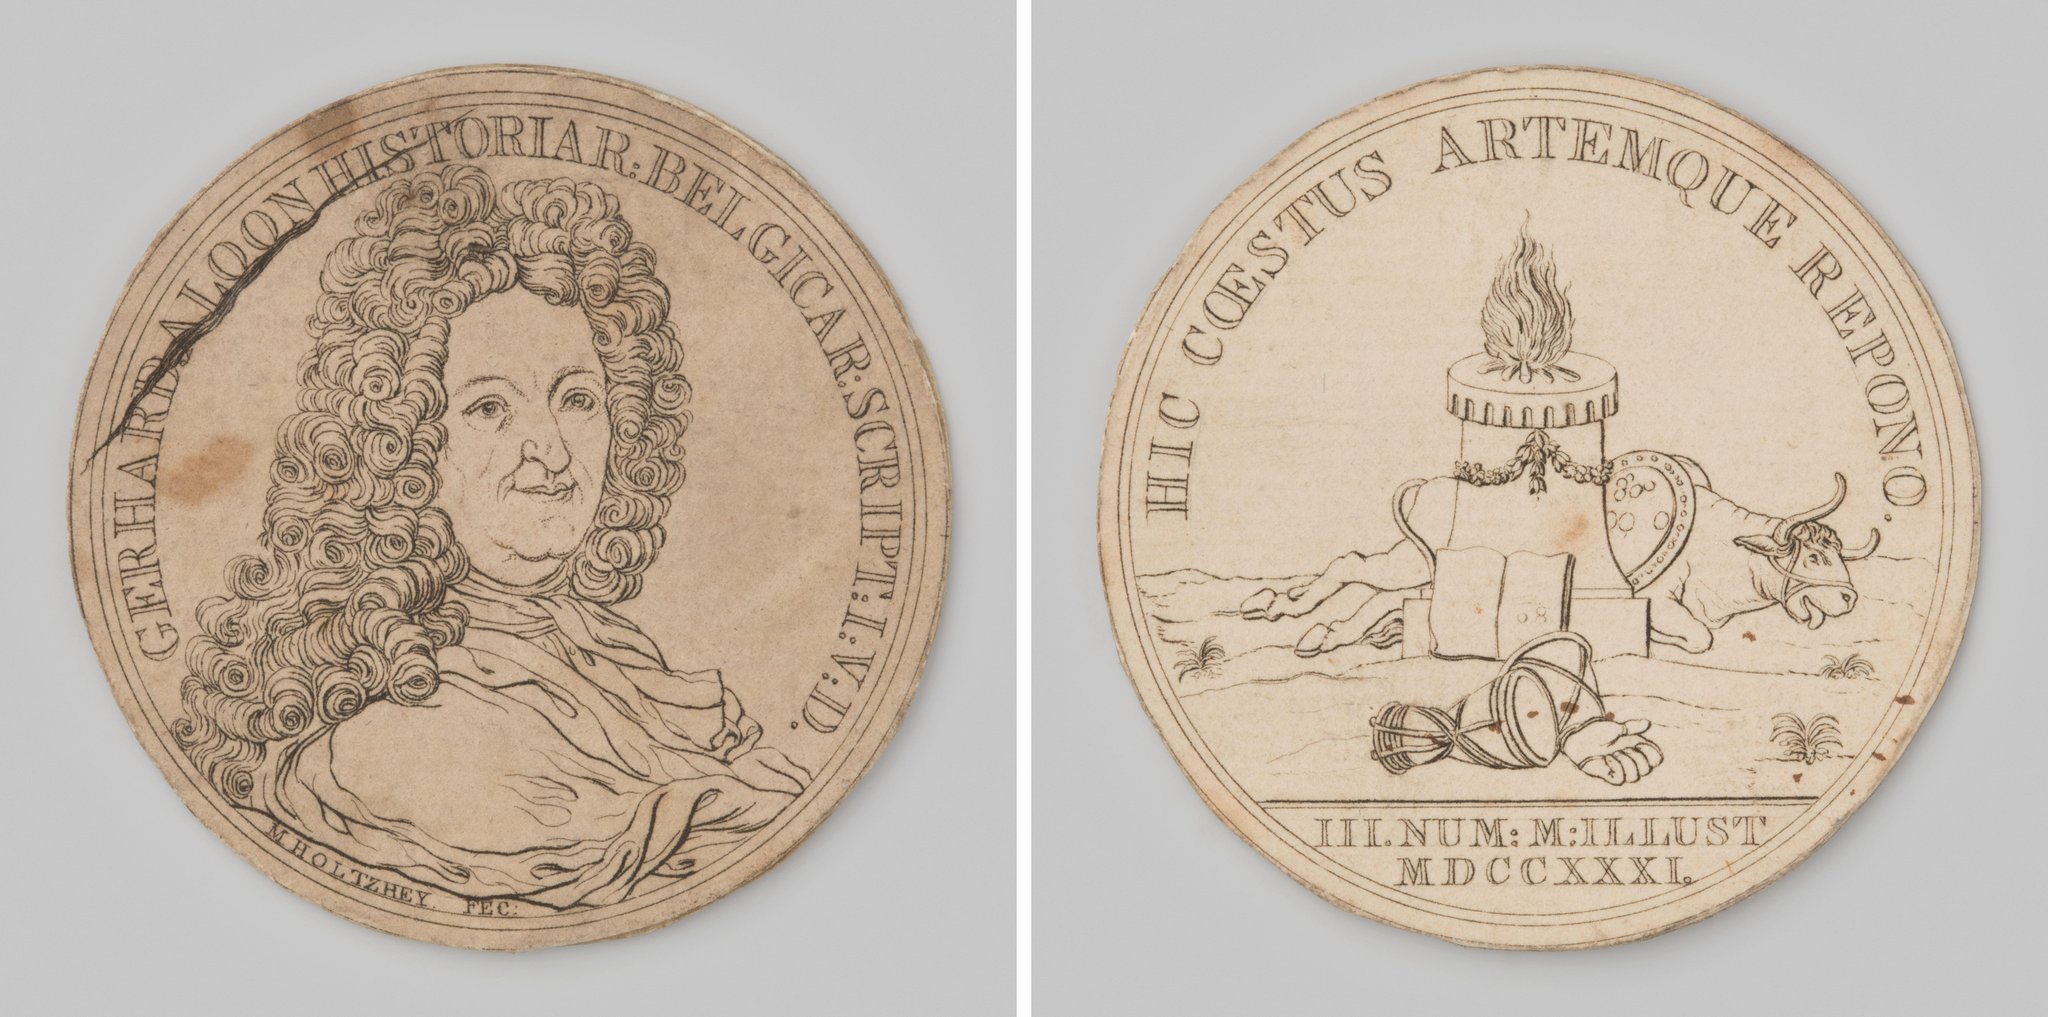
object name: history medal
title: Voltooiing van de beschrijving der Nederlandse penningen door Gerard van Loon 1731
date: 1731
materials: paper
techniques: printing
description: De gedrukte afbeeldingen uit "Vervolg op Van Loon" aaneengeplakt, op de voorzijde het borstbeeld van Van Loon naar rechts met omschrift, op de keerzijde een dode os en vuistvechtershandschoenen bij een brandend altaar, met omschrift en afsnedetekst.